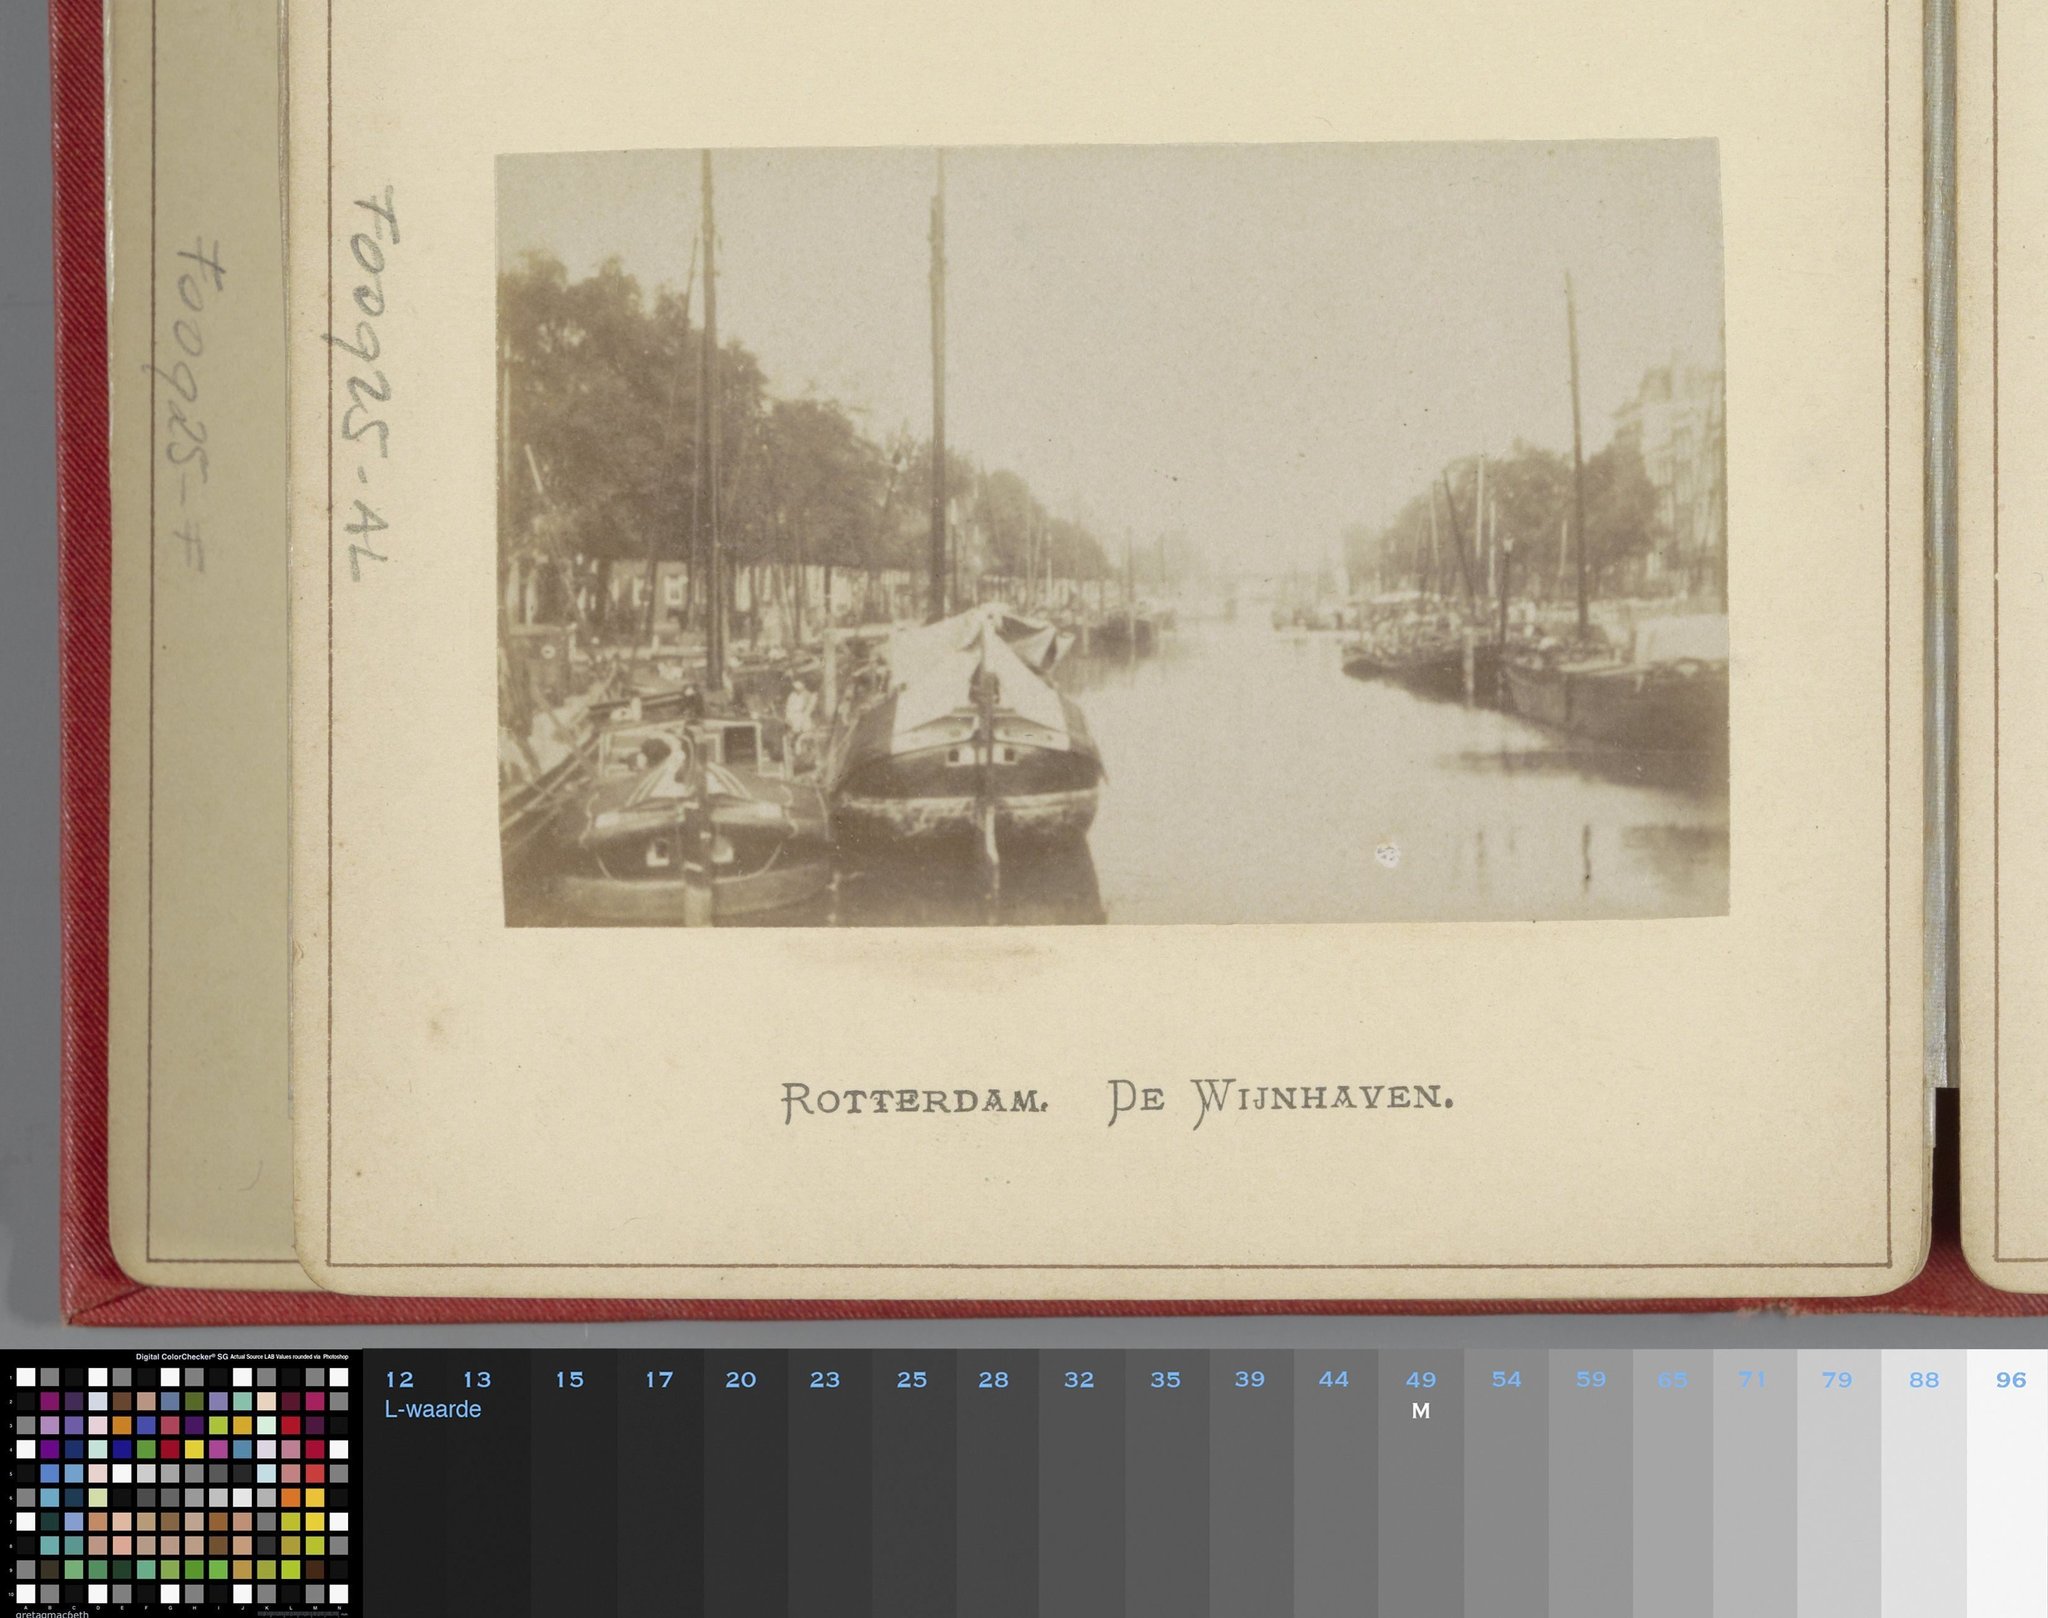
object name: photograph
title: Gezicht op de Wijnhaven in Rotterdam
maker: andries jager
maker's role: publisher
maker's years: 1825-1905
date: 1860-1900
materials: cardboard, photographic support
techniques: albumen print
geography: rotterdam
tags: harbour (+ view ~ vehicle, ship, etc.), canal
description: Onderdeel van Fotoalbum met opnames van steden in Noord- en Zuid-Holland en Utrecht.